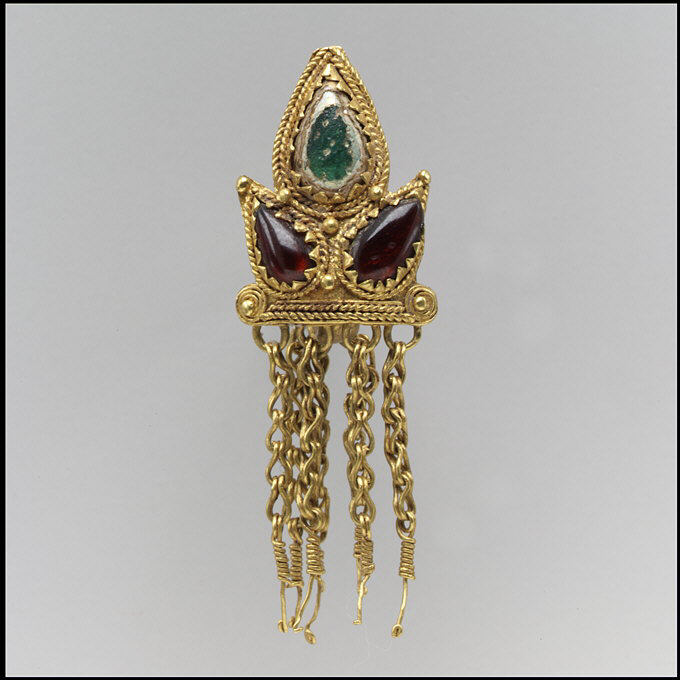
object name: earring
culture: sarmatian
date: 34-66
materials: garnet, glass, gold